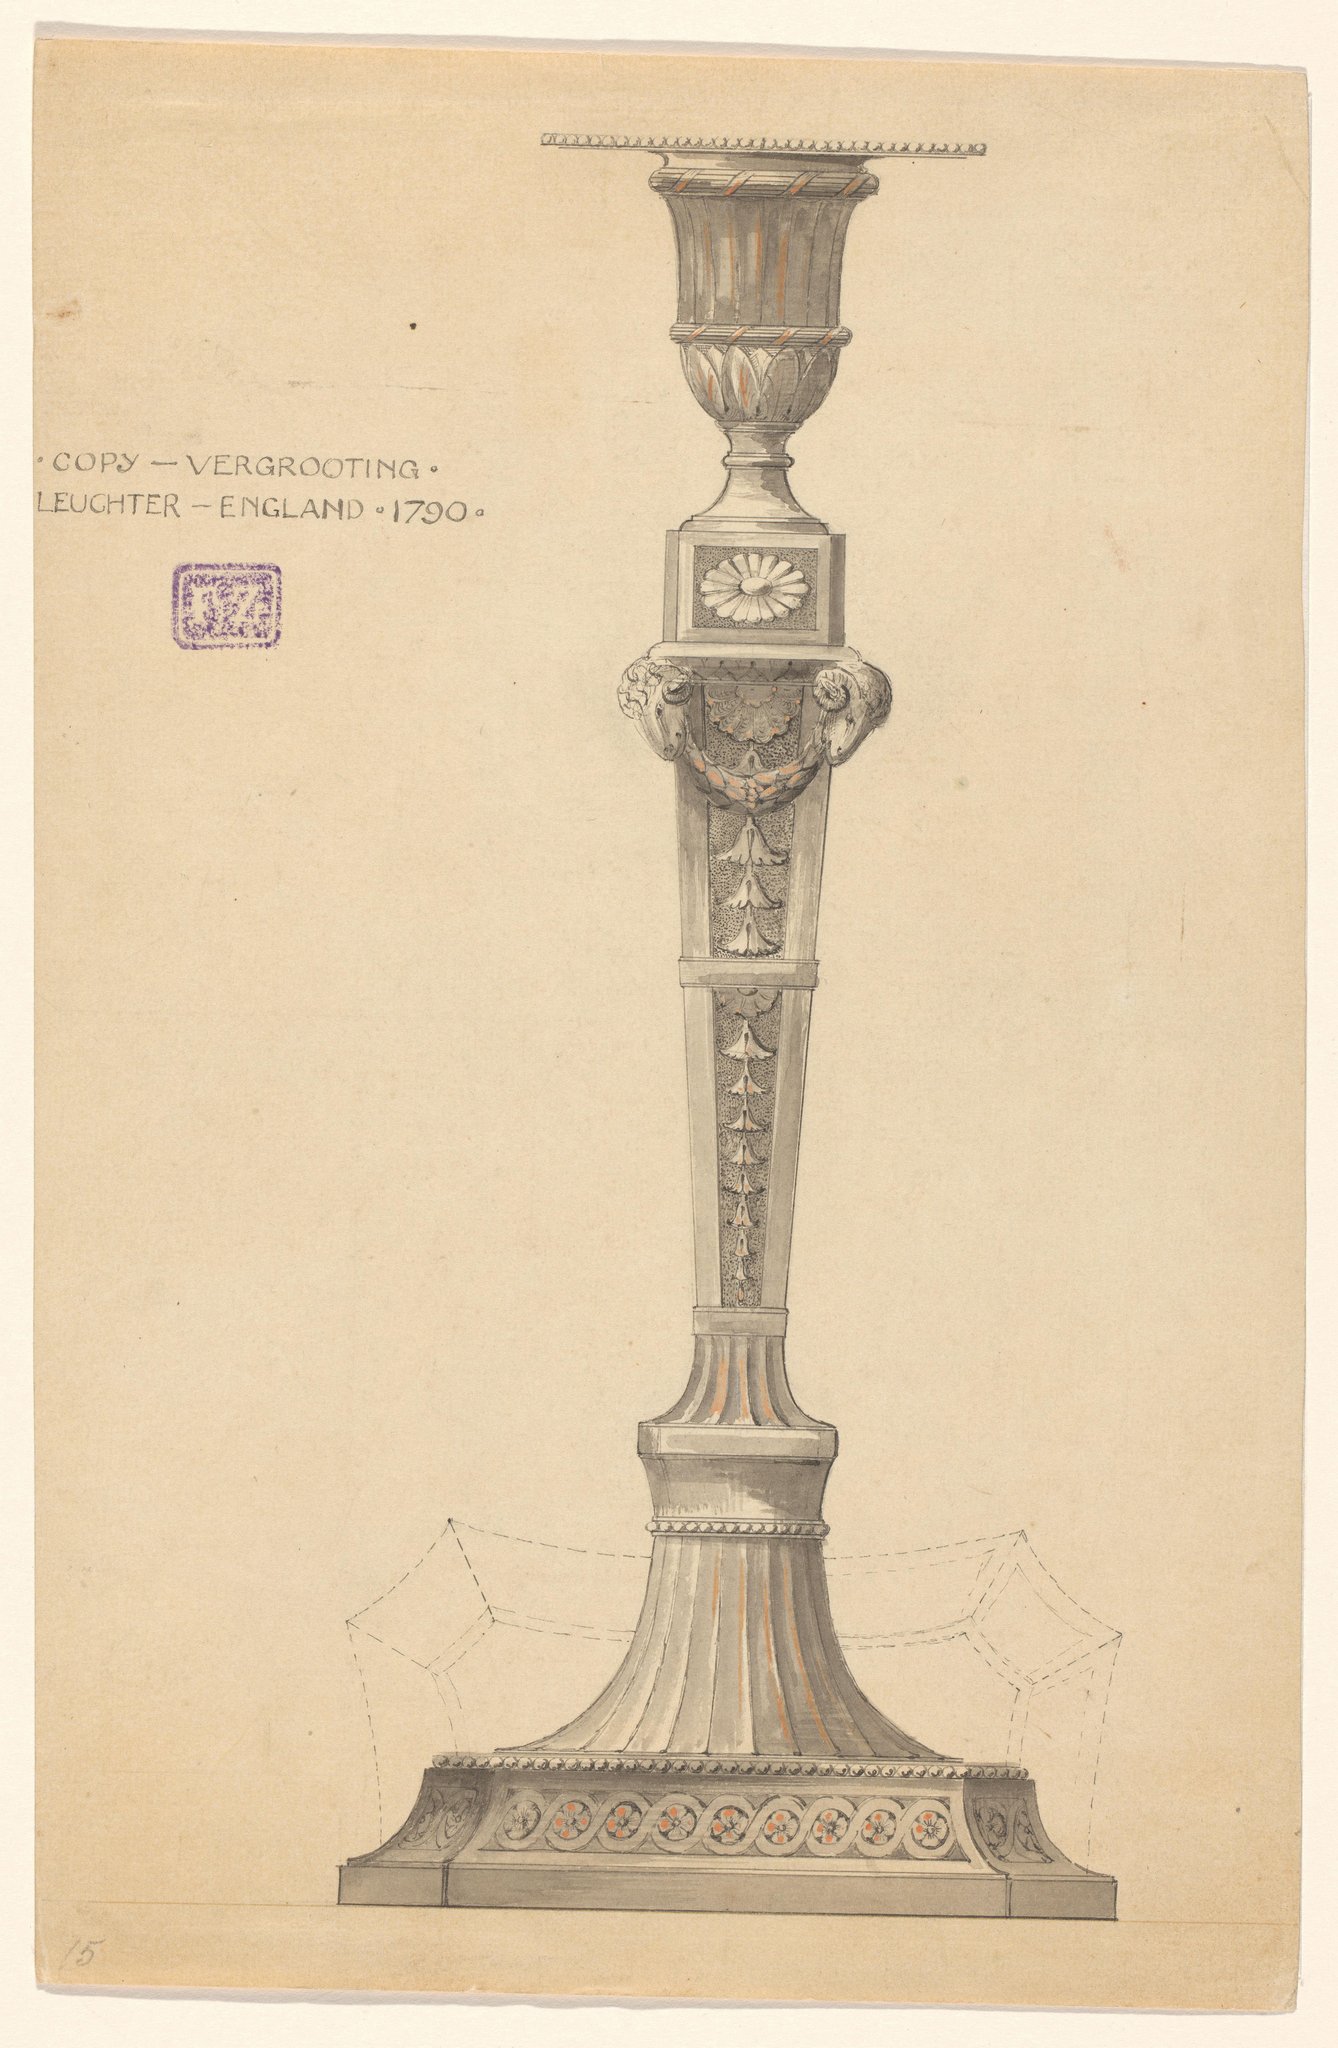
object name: drawing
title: Kandelaar in neo-classicistische stijl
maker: frans zwollo (i)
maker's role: silversmith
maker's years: 1872-1945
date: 1895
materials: graphite, ink, paper, watercolor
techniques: brush, pen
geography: netherlands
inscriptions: stamp: ‘FZ’, watermark, inscription: ‘•COPY - VERGROOTING• / LEUCHTER – ENGLAND ˚1790 ˚’, number: ‘15’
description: Kandelaar met daarachter de plattegrond van de helft van de voet.